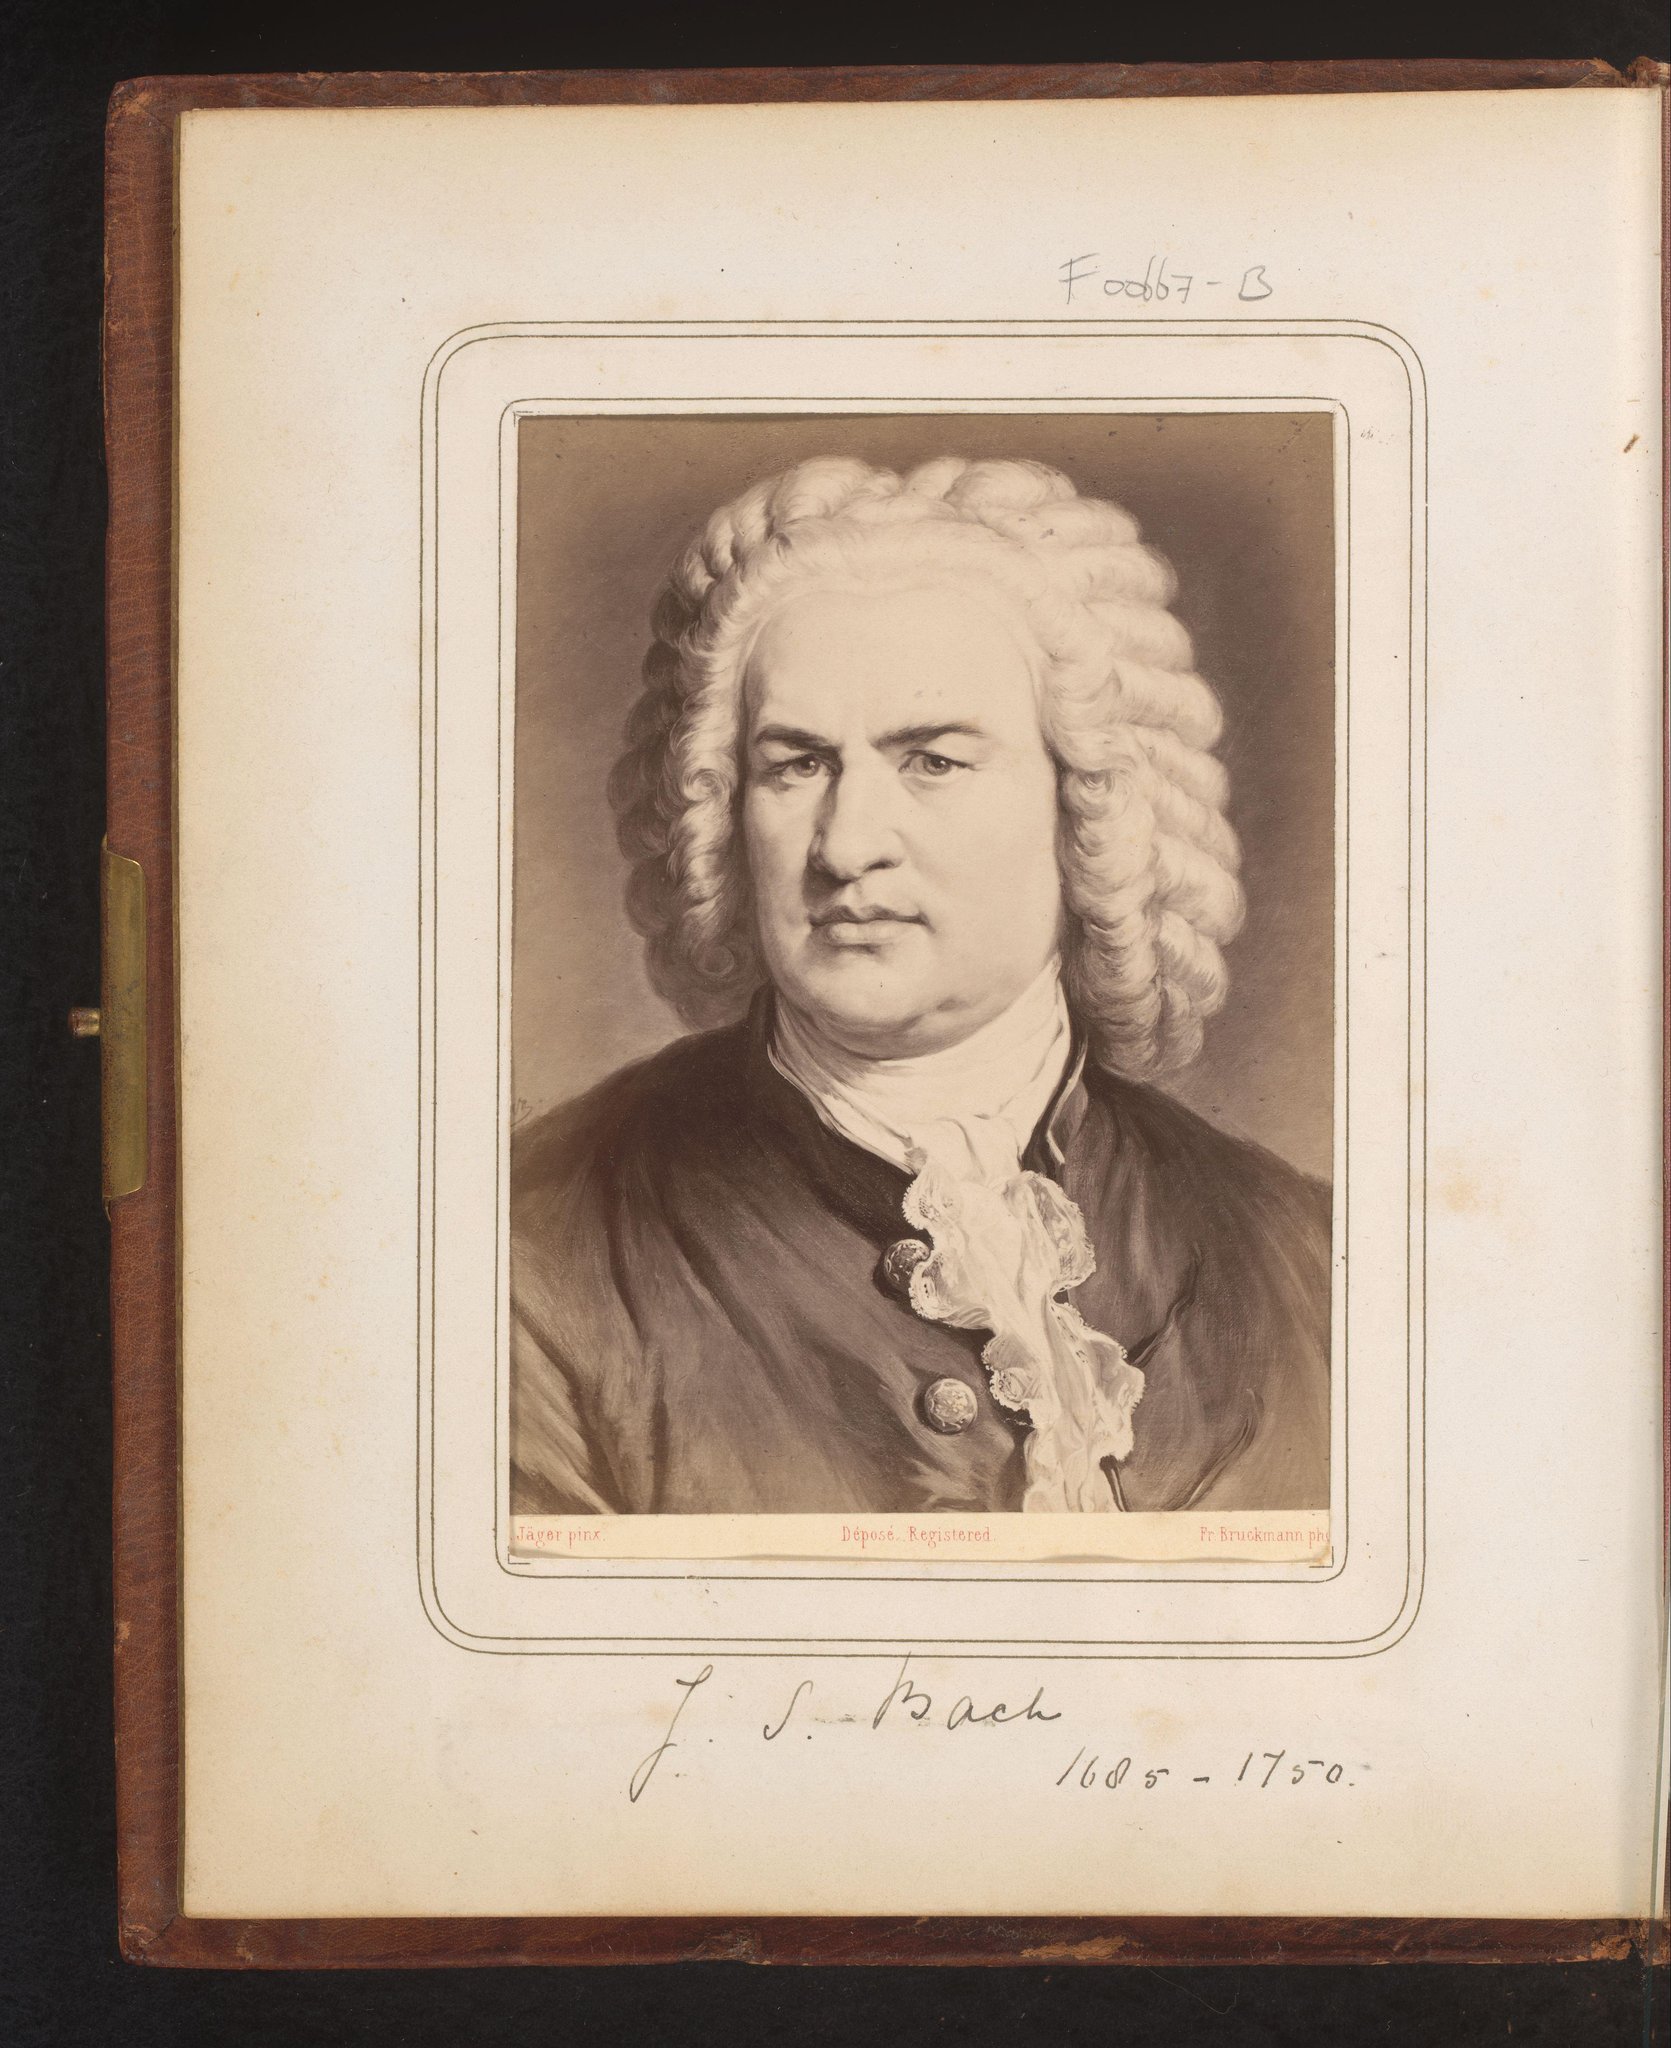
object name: cabinet photograph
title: Fotoreproductie van een geschilderd portret van Johann Sebastian Bach door Carl Jaeger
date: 1870-1890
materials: cardboard, photographic support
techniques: albumen print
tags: historical persons, portrait of composer, picture, painting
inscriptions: annotation: ‘J. S. Bach/ 1685 - 1750’, name: ‘Jäger pinx. Désposé Registered. Fr. Bruckmann pho[...]’